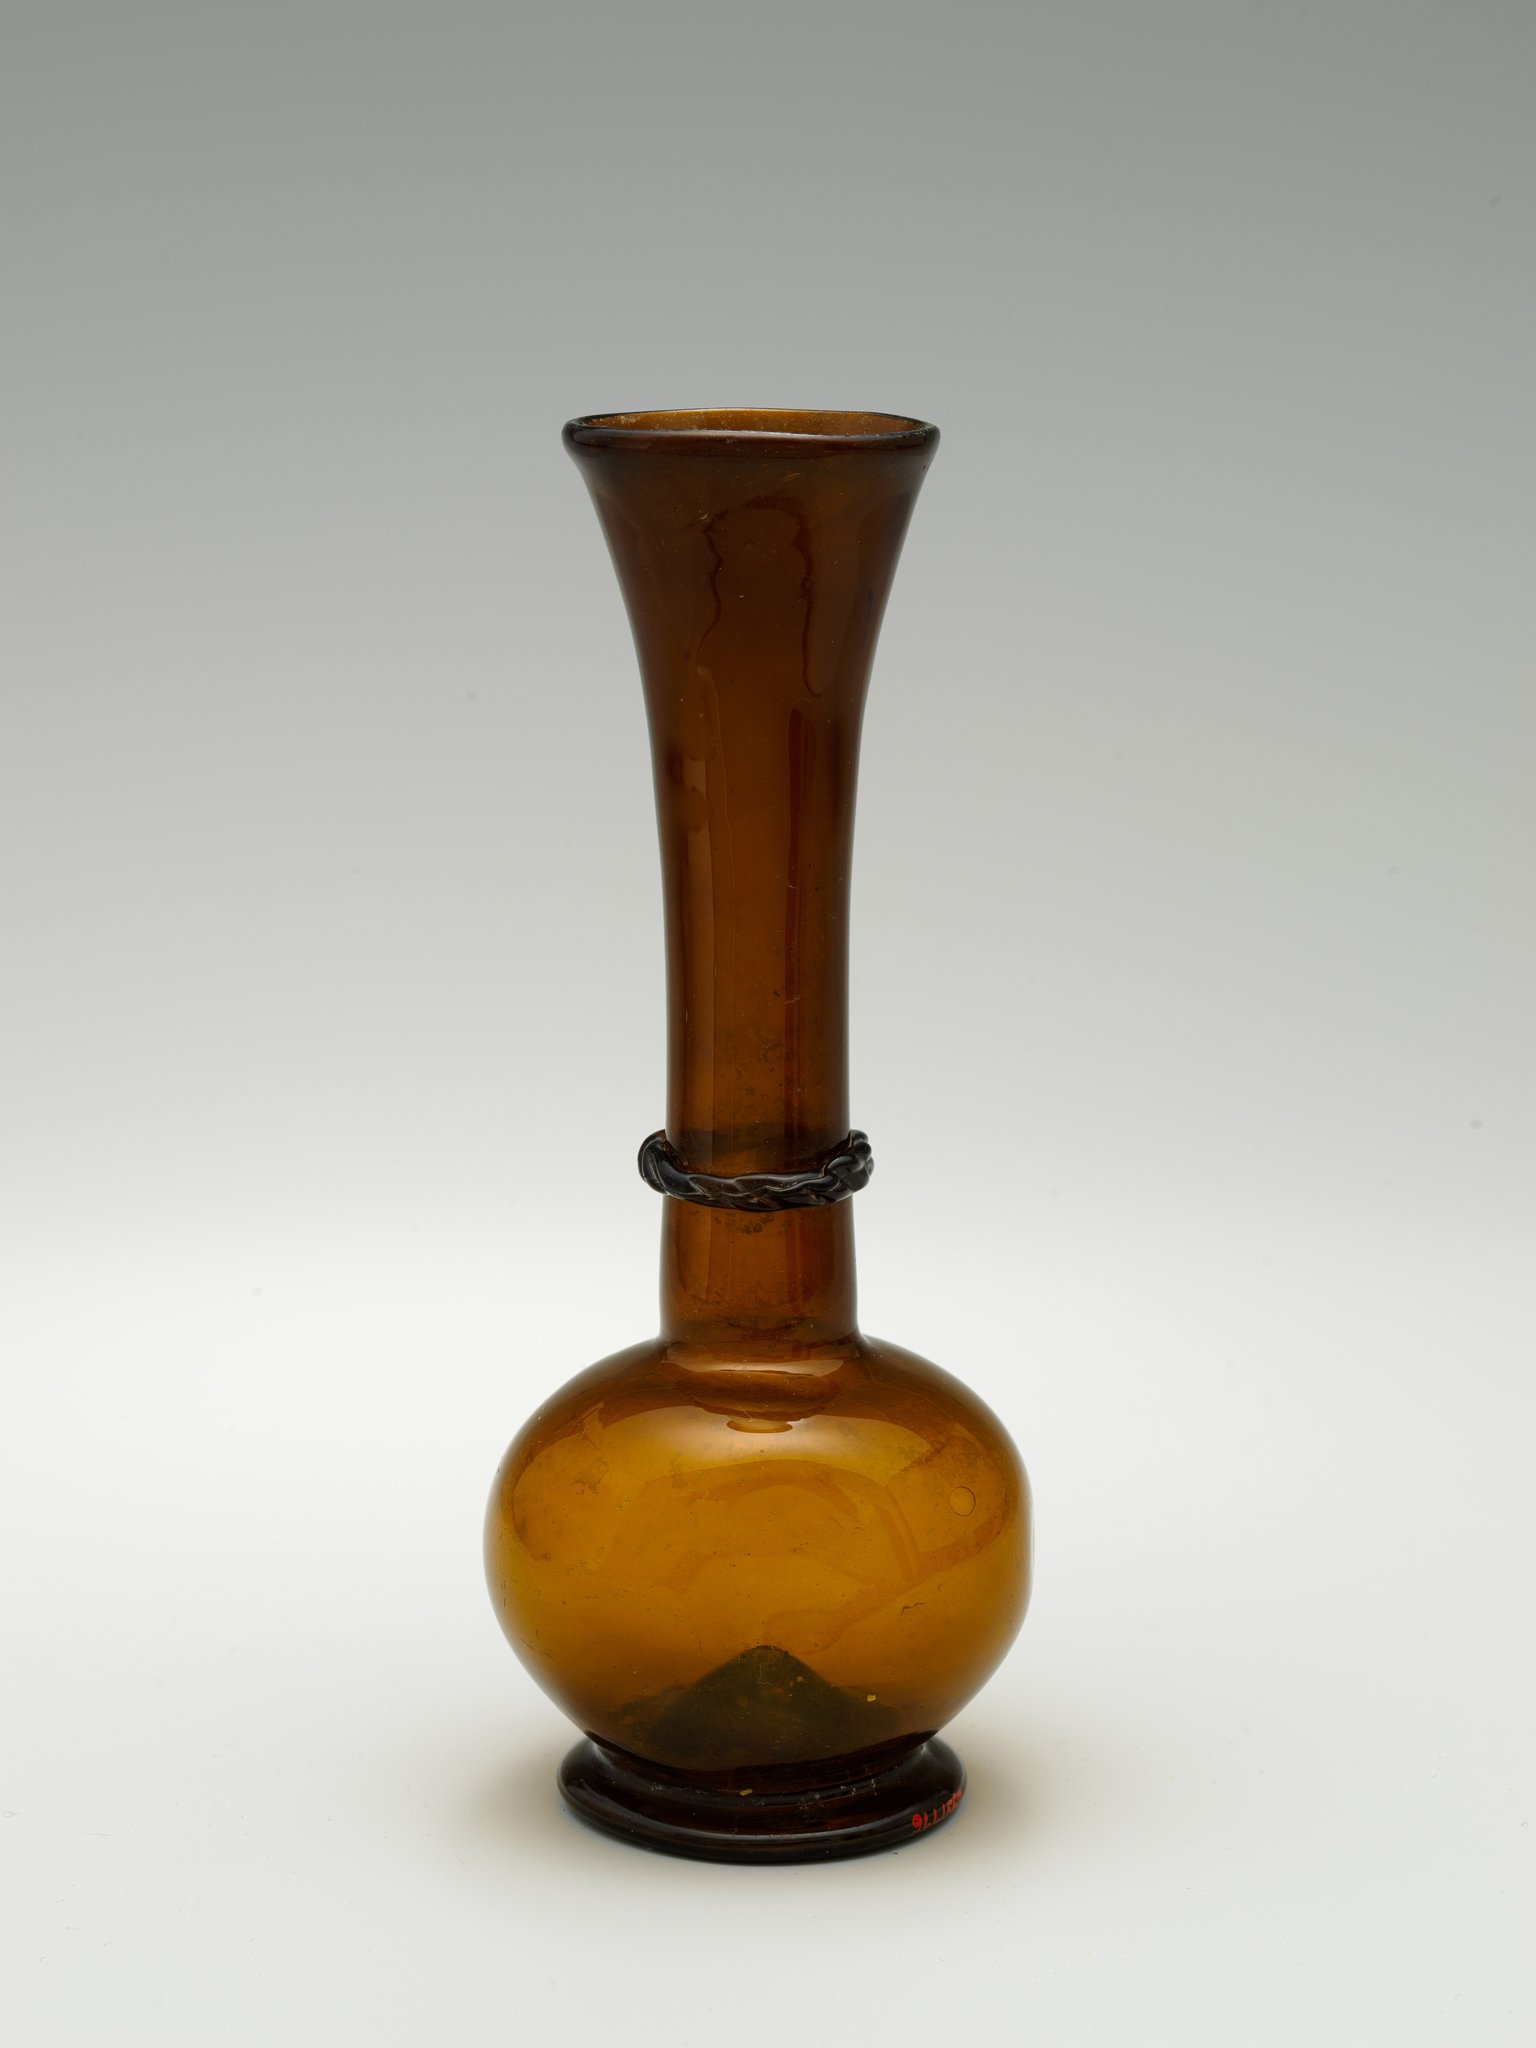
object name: vase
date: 1701-1900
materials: glass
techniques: glassblowing, tooling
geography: iran